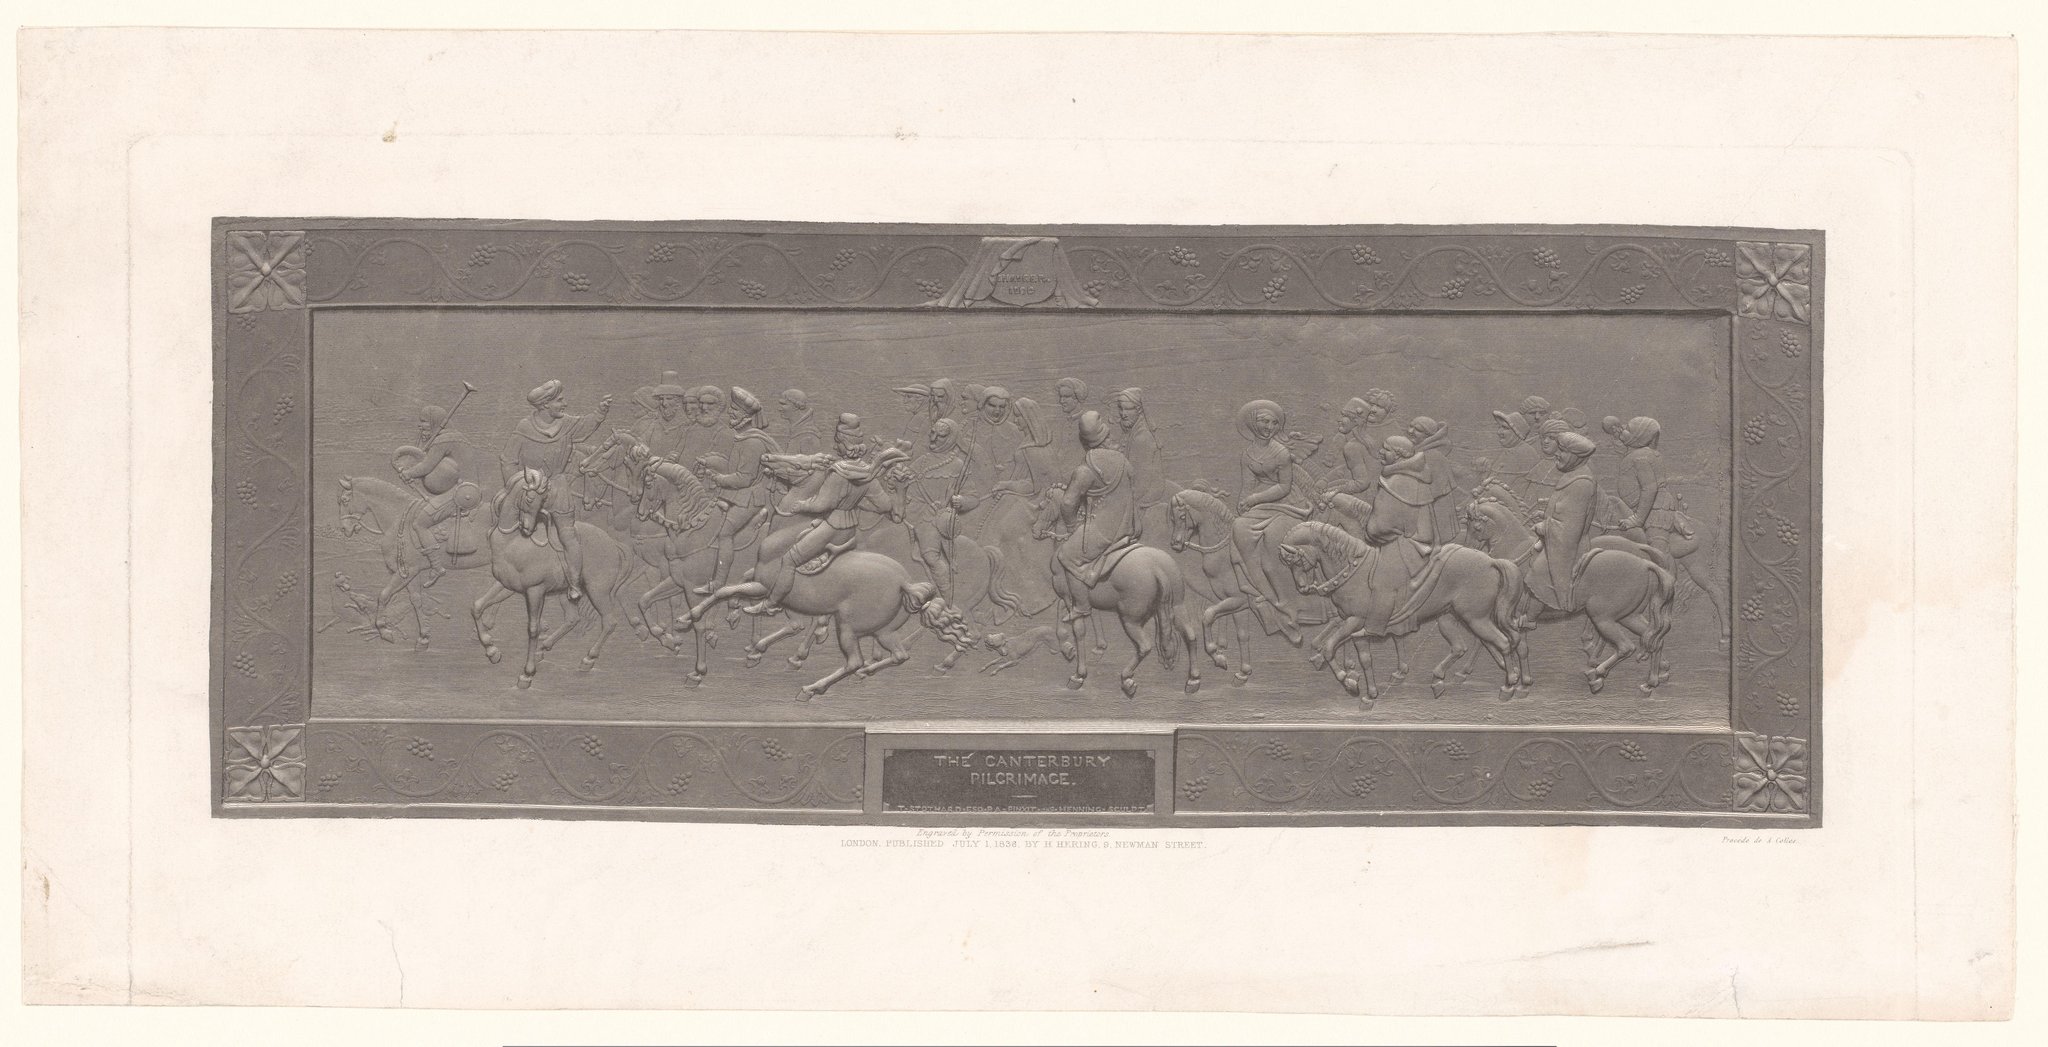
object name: print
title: The Canterbury pilgrimage.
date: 1836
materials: paper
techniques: relief engraving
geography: france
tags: ornament ~ medallion, 'en route', traveller under way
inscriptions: collector's mark: Lugt 2228